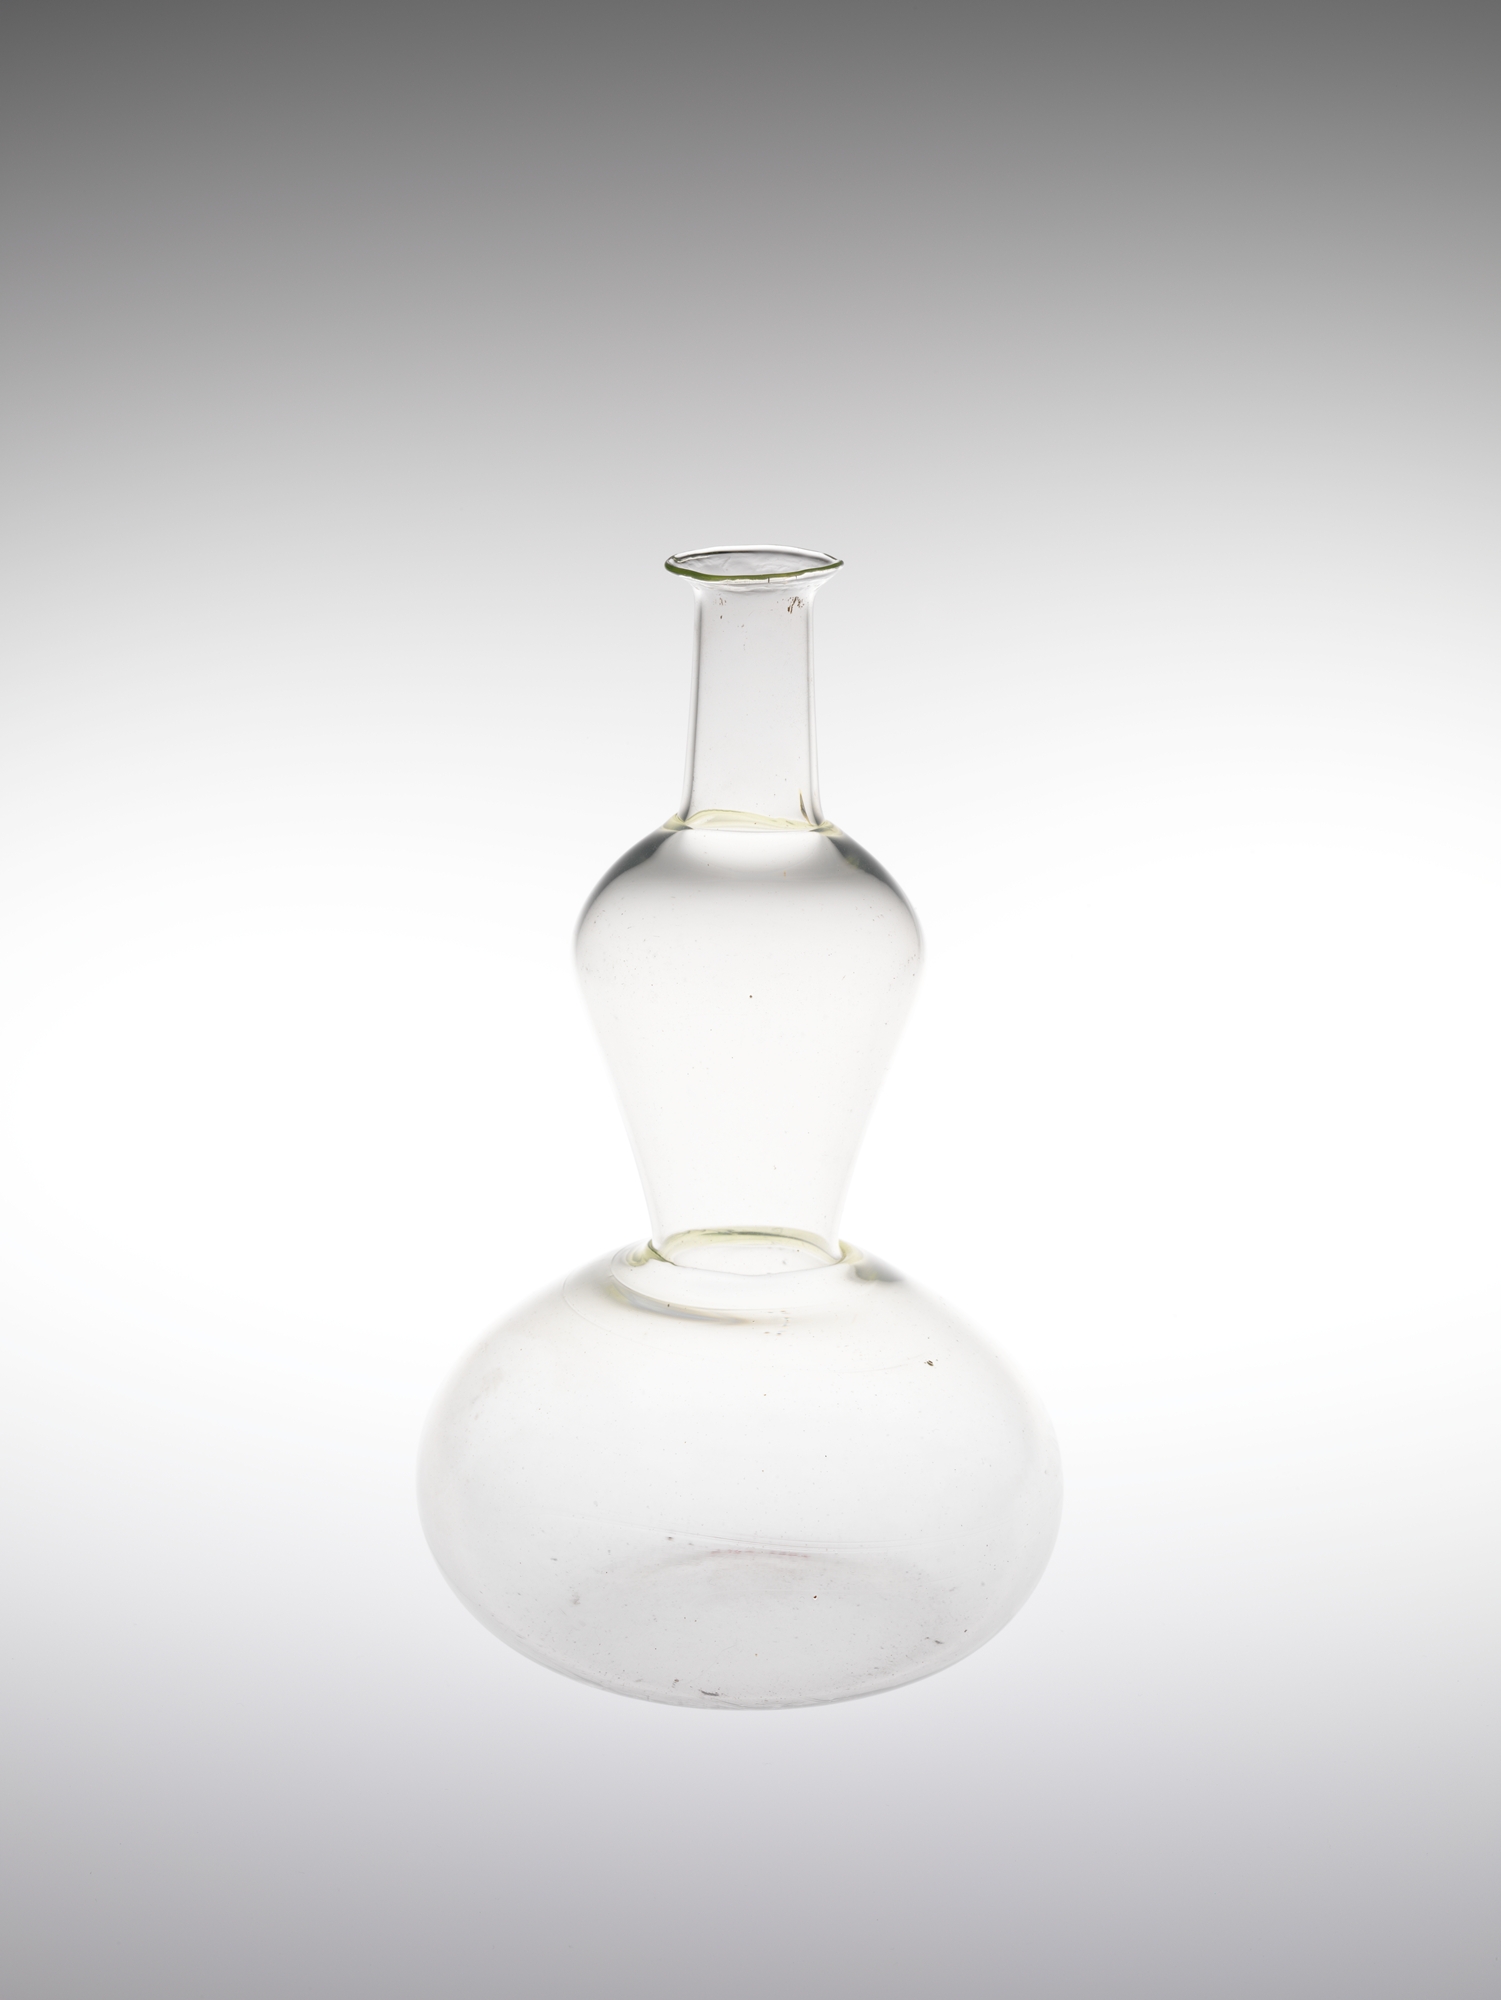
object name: wine bottle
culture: japanese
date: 1801-1900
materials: glass